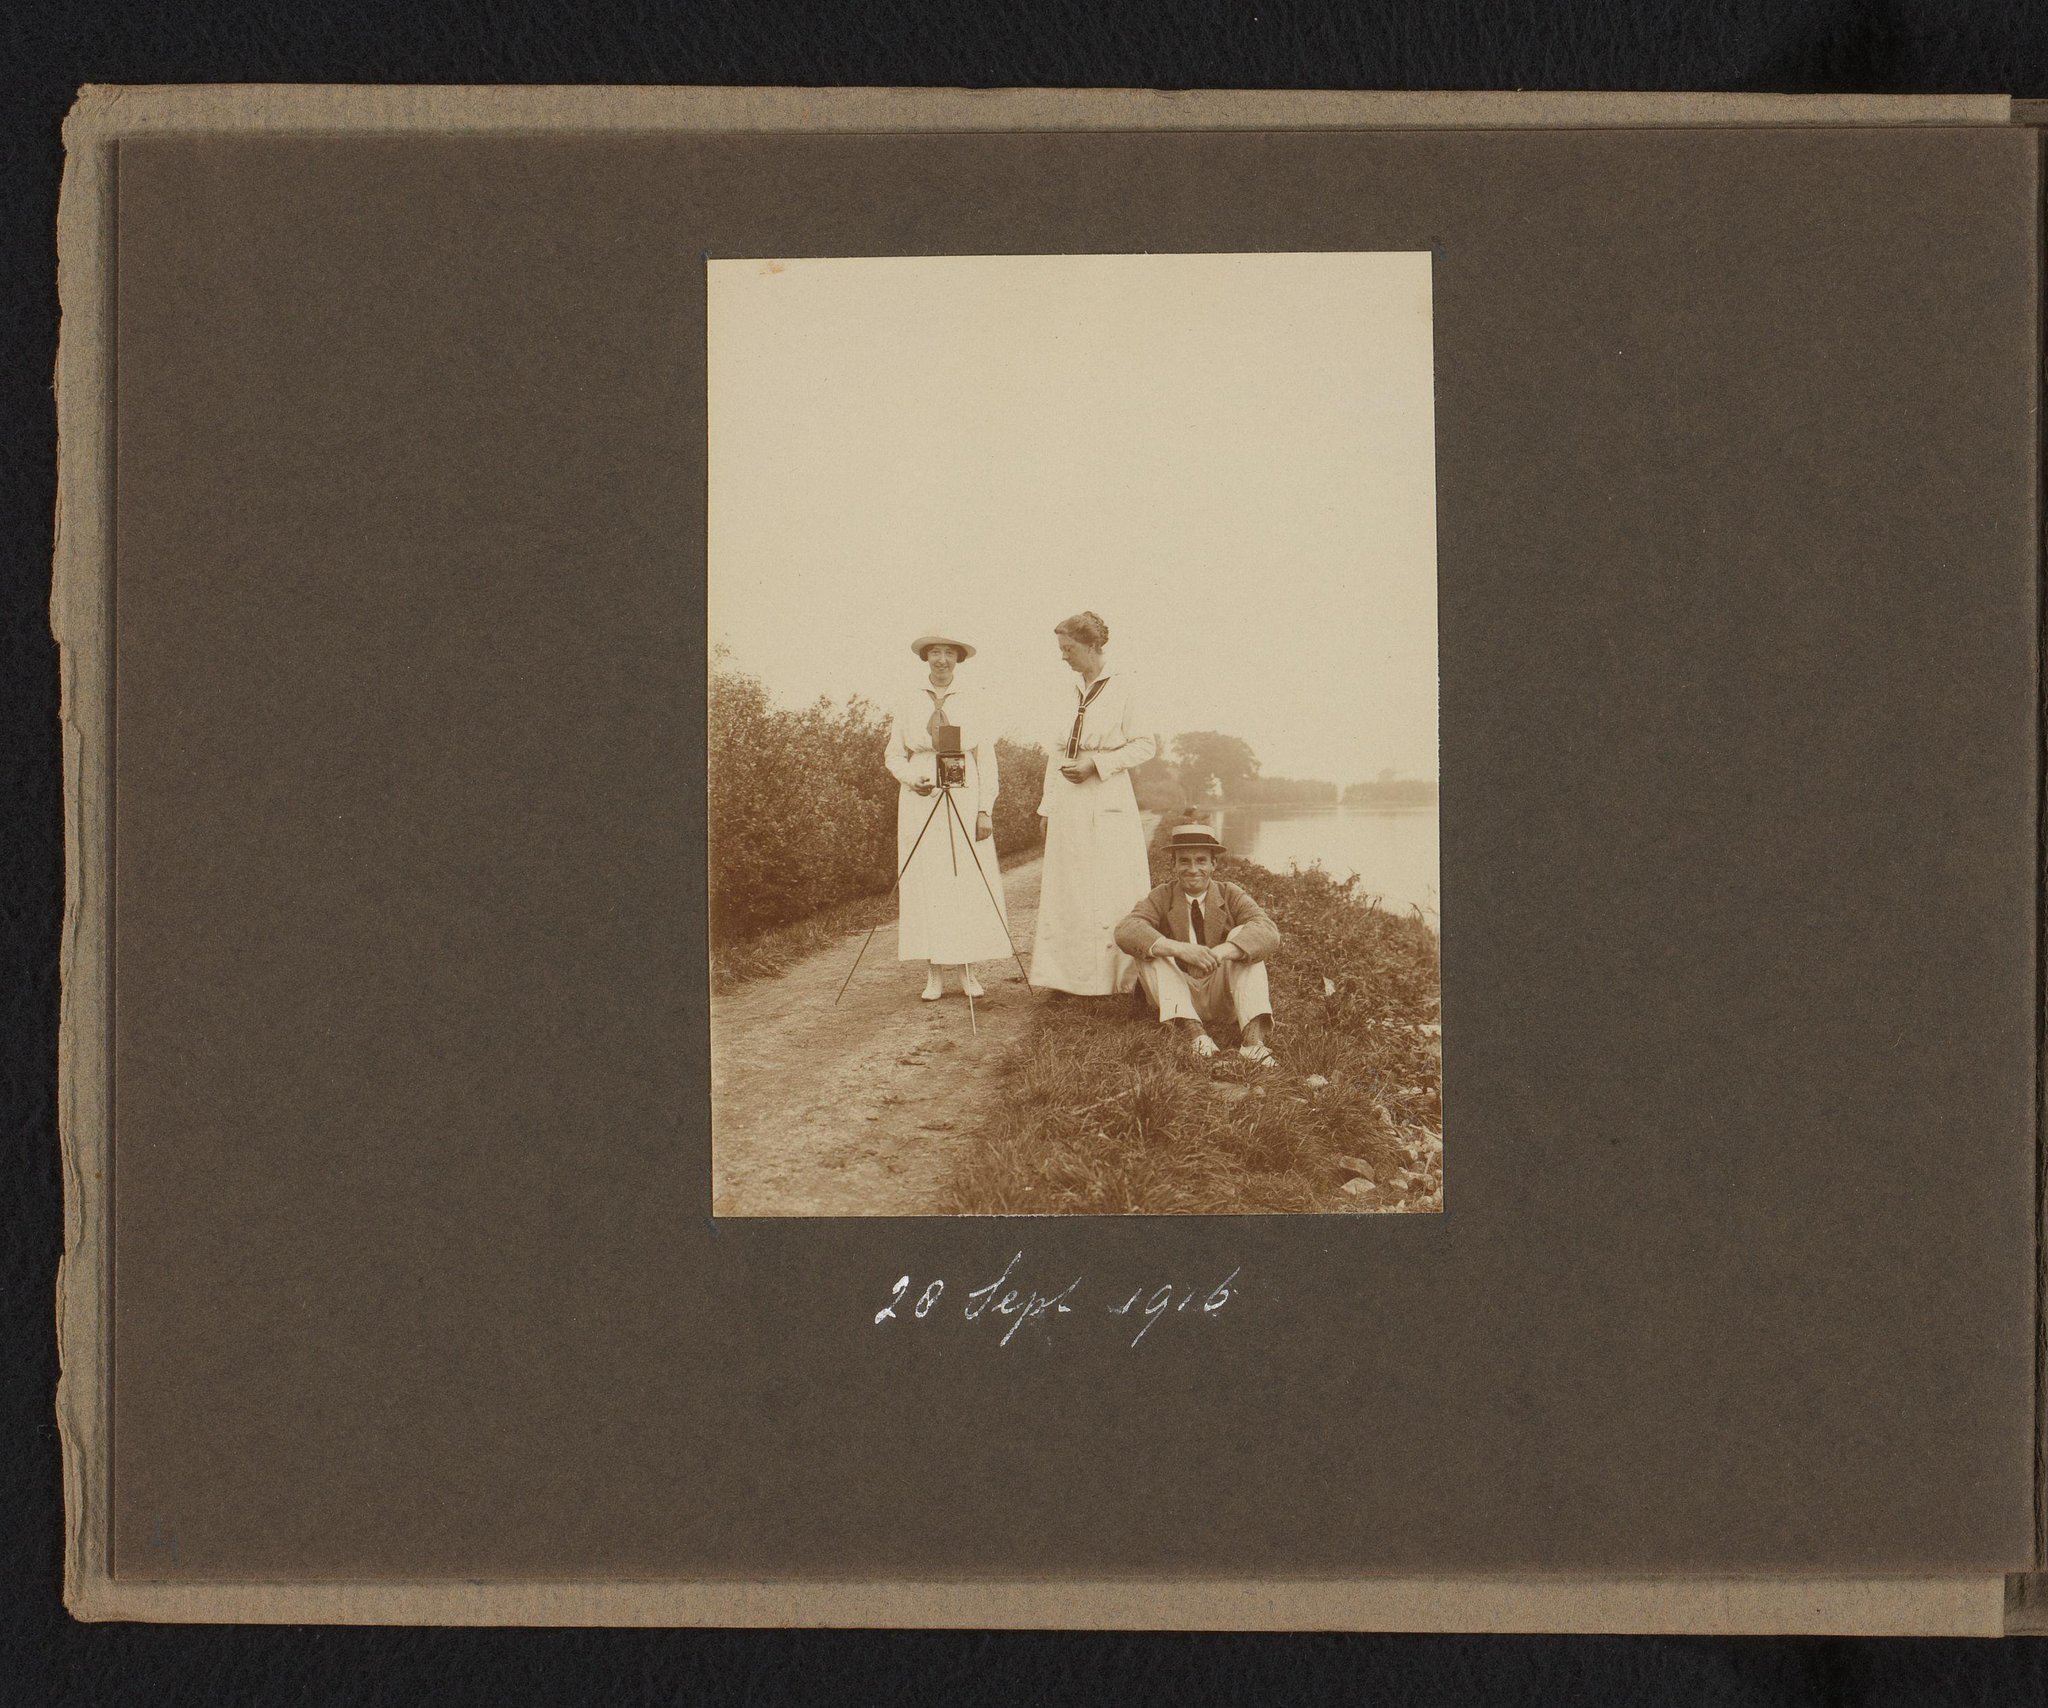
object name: album leaf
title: Twee vrouwen en een man langs de Amstel, een vrouw bedient de camera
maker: Anonymous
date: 1916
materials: paper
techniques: matte daylight collodion silver print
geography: amstel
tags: taking photographs - cc - out of doors, adult man, adult woman (+ two persons)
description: De vrouw maakt waarschijnlijk foto RP-F-2003-5-5.